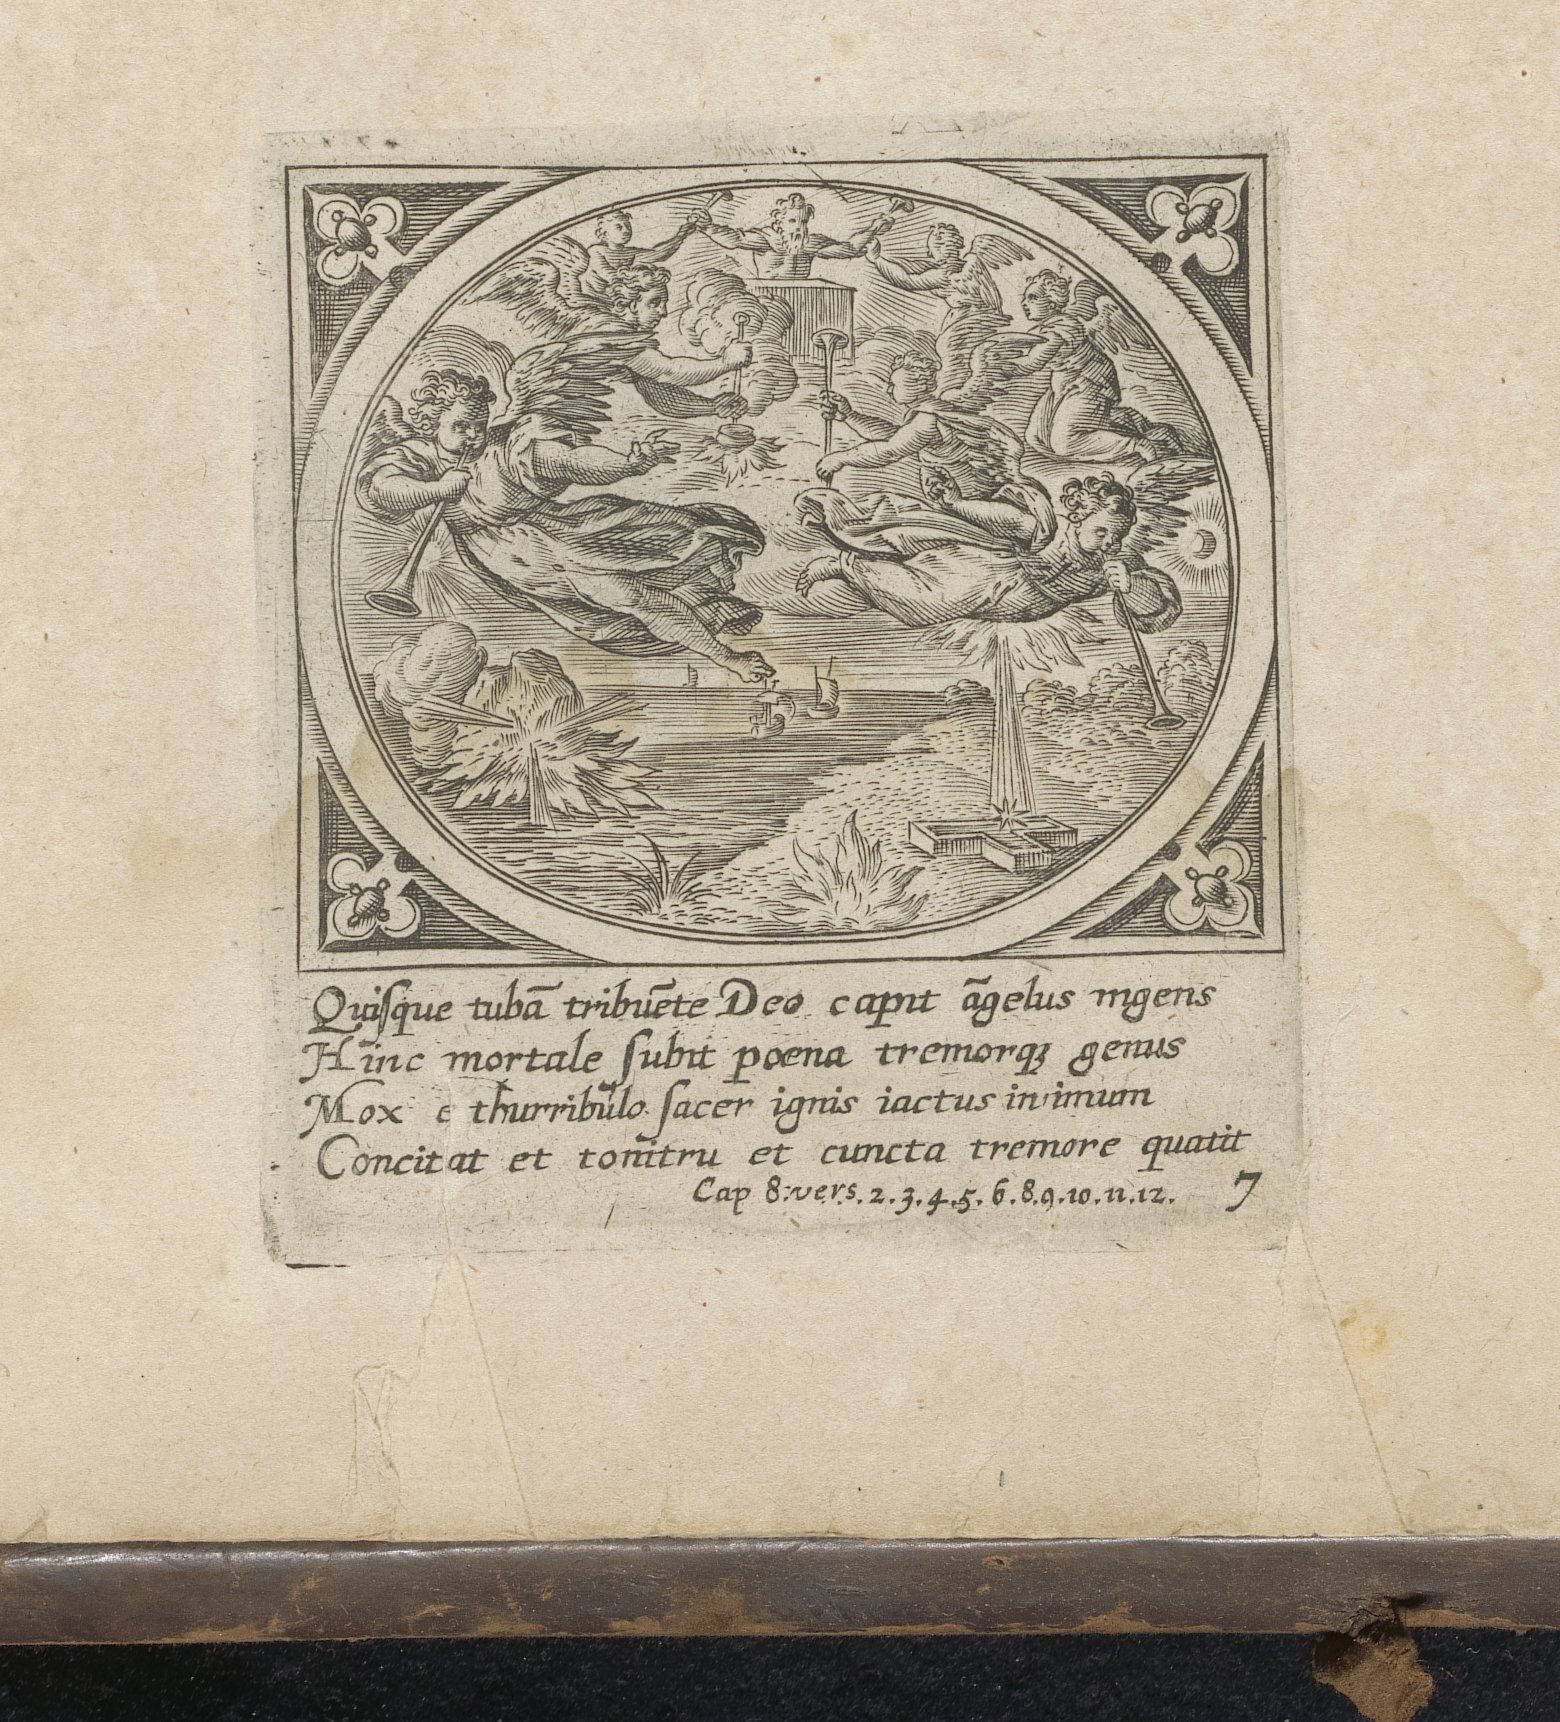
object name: album leaf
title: Icones Revelationum S Iohs Evangeliste in Pathmo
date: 1585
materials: paper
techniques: engraving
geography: alkmaar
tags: the seven angels with trumpets ~ revelation of john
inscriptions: number: ‘20[8]’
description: Het openen van het zevende zegel: in de wolken God de Vader en zeven engelen met een bazuin. Onder hen de aarde waarop bliksemschichten neerkomen. Onder de voorstelling een verwijzing in het Latijn naar de Bijbeltekst in Op. 8. Deze prent maakt deel uit van een album.